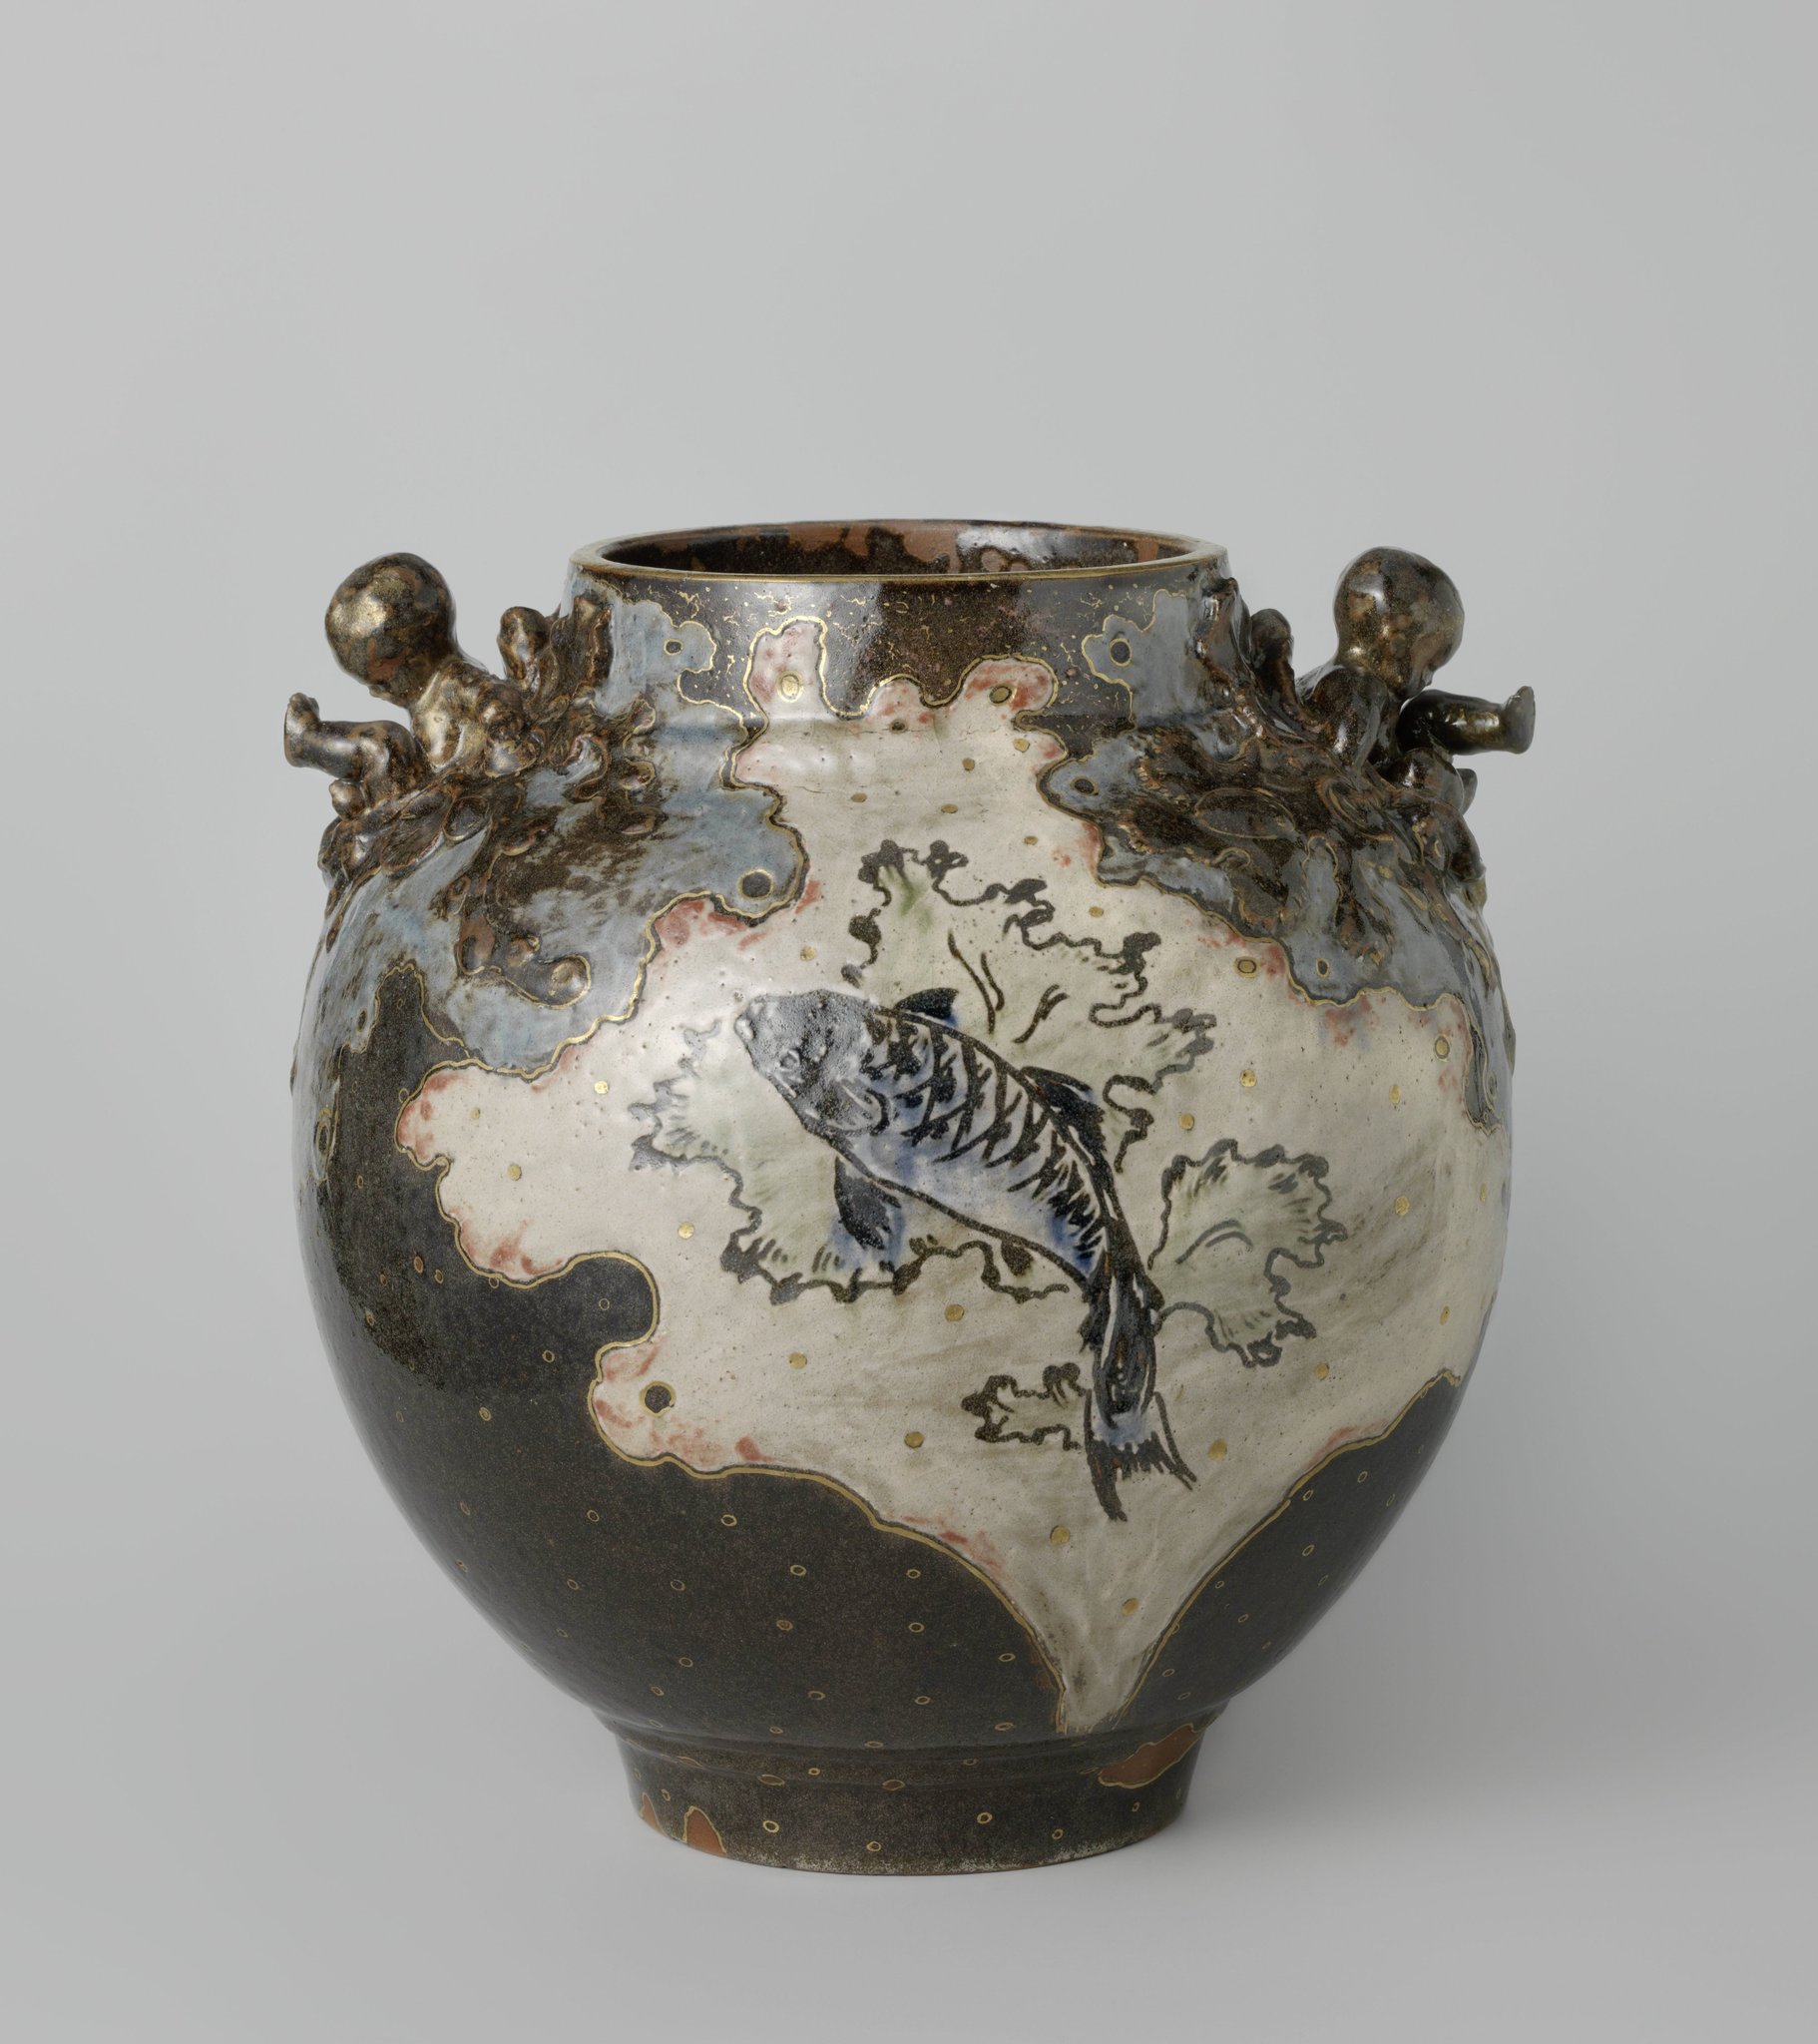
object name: vase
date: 1885-1886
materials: glaze, stoneware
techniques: gilding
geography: paris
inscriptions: inscription: ‘60 / 40’, signature: ‘Edouard. D.’, mark: ‘H & Co in rozenkrans’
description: The decorations on this vase refer to the sea. Both sides feature fish, inspired by Japanese prints. The handles are infants, and around them seaweed and shells. The coloured decoration was produced using an experimental technique in which randomly produced patterns were embellished in the glaze. Edouard Dammouse, a key painter at Ernest Chaplet’s workplace applied the decoration.